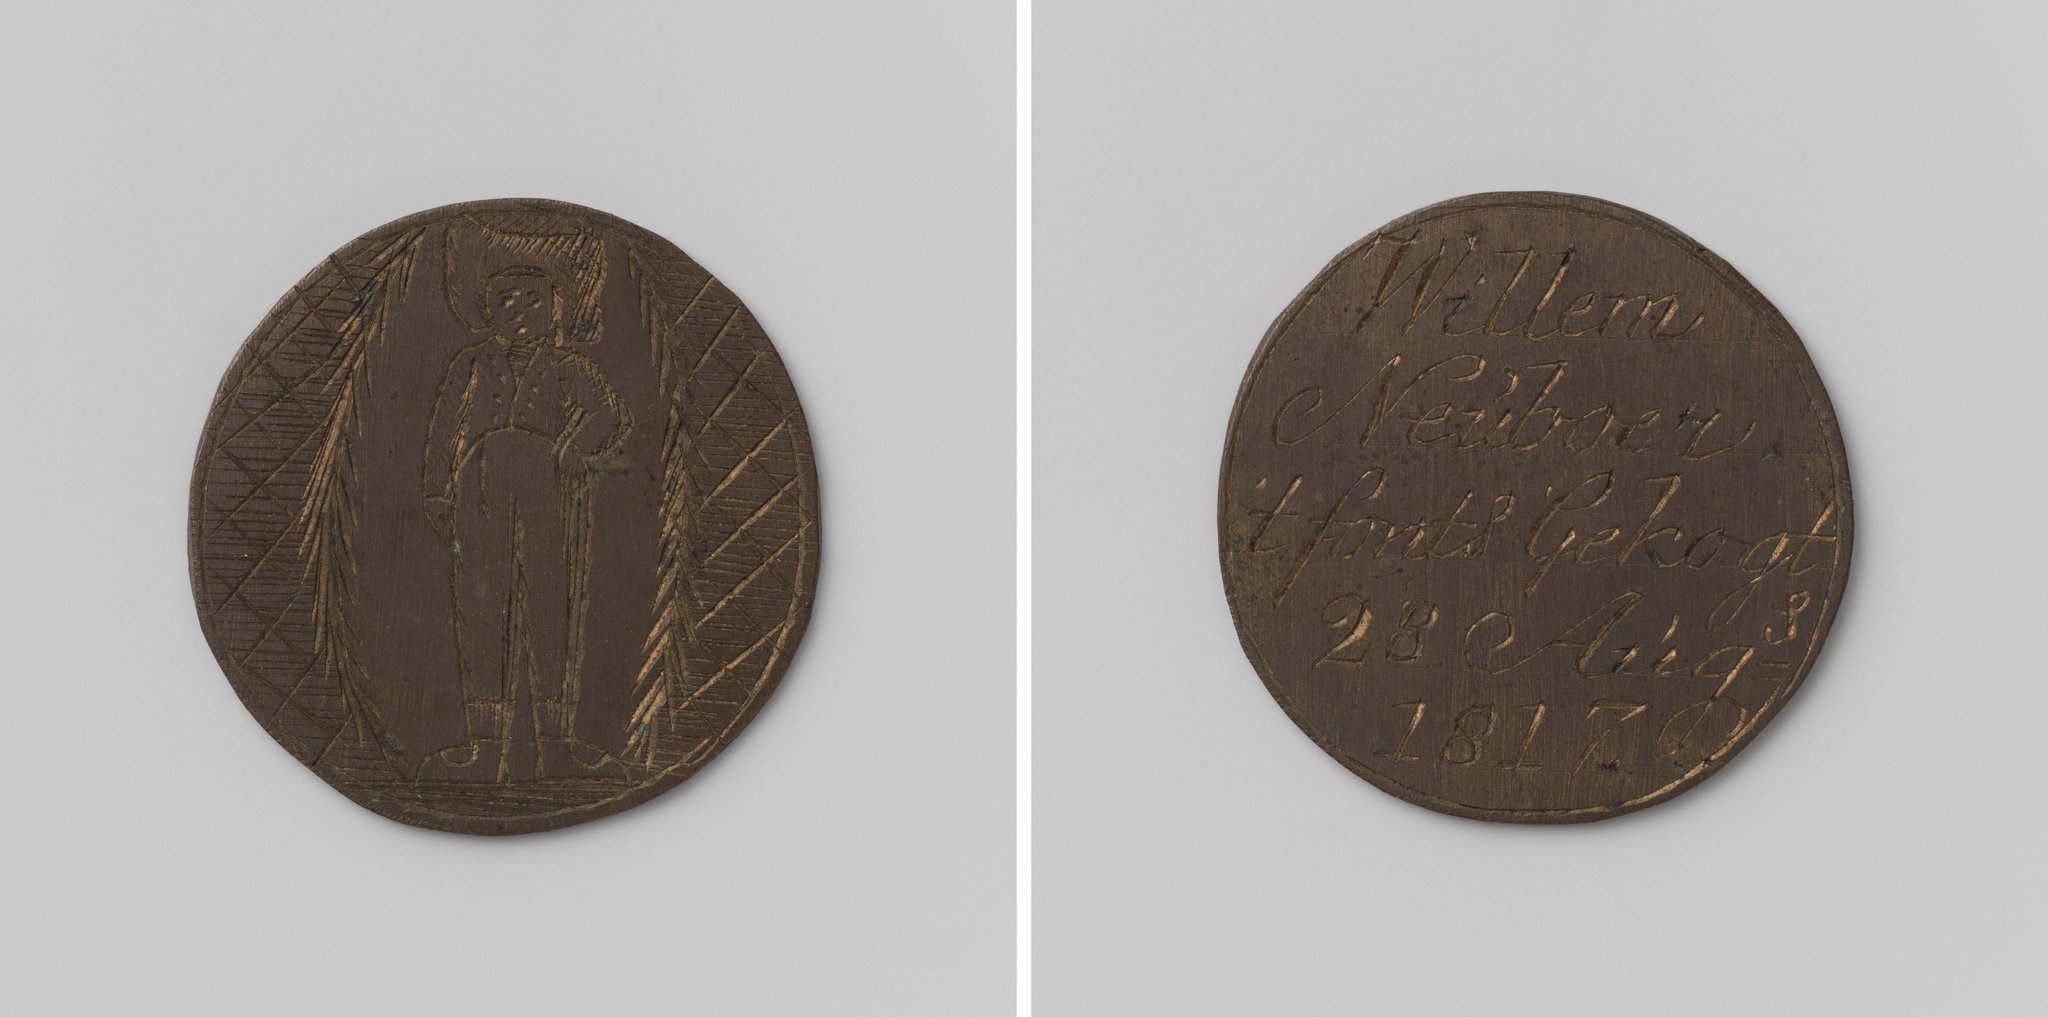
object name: medal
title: Korendragers- en -stortersgilde van Amsterdam, gildepenning van Willem Neuboer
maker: Anonymous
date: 1817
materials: brass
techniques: engraving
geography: amsterdam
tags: amsterdam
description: Messing penning. Voorzijde: man met last op hoofd en face binnen bladerkrans; achtergrond: gearceerd. Keerzijde: opschrift